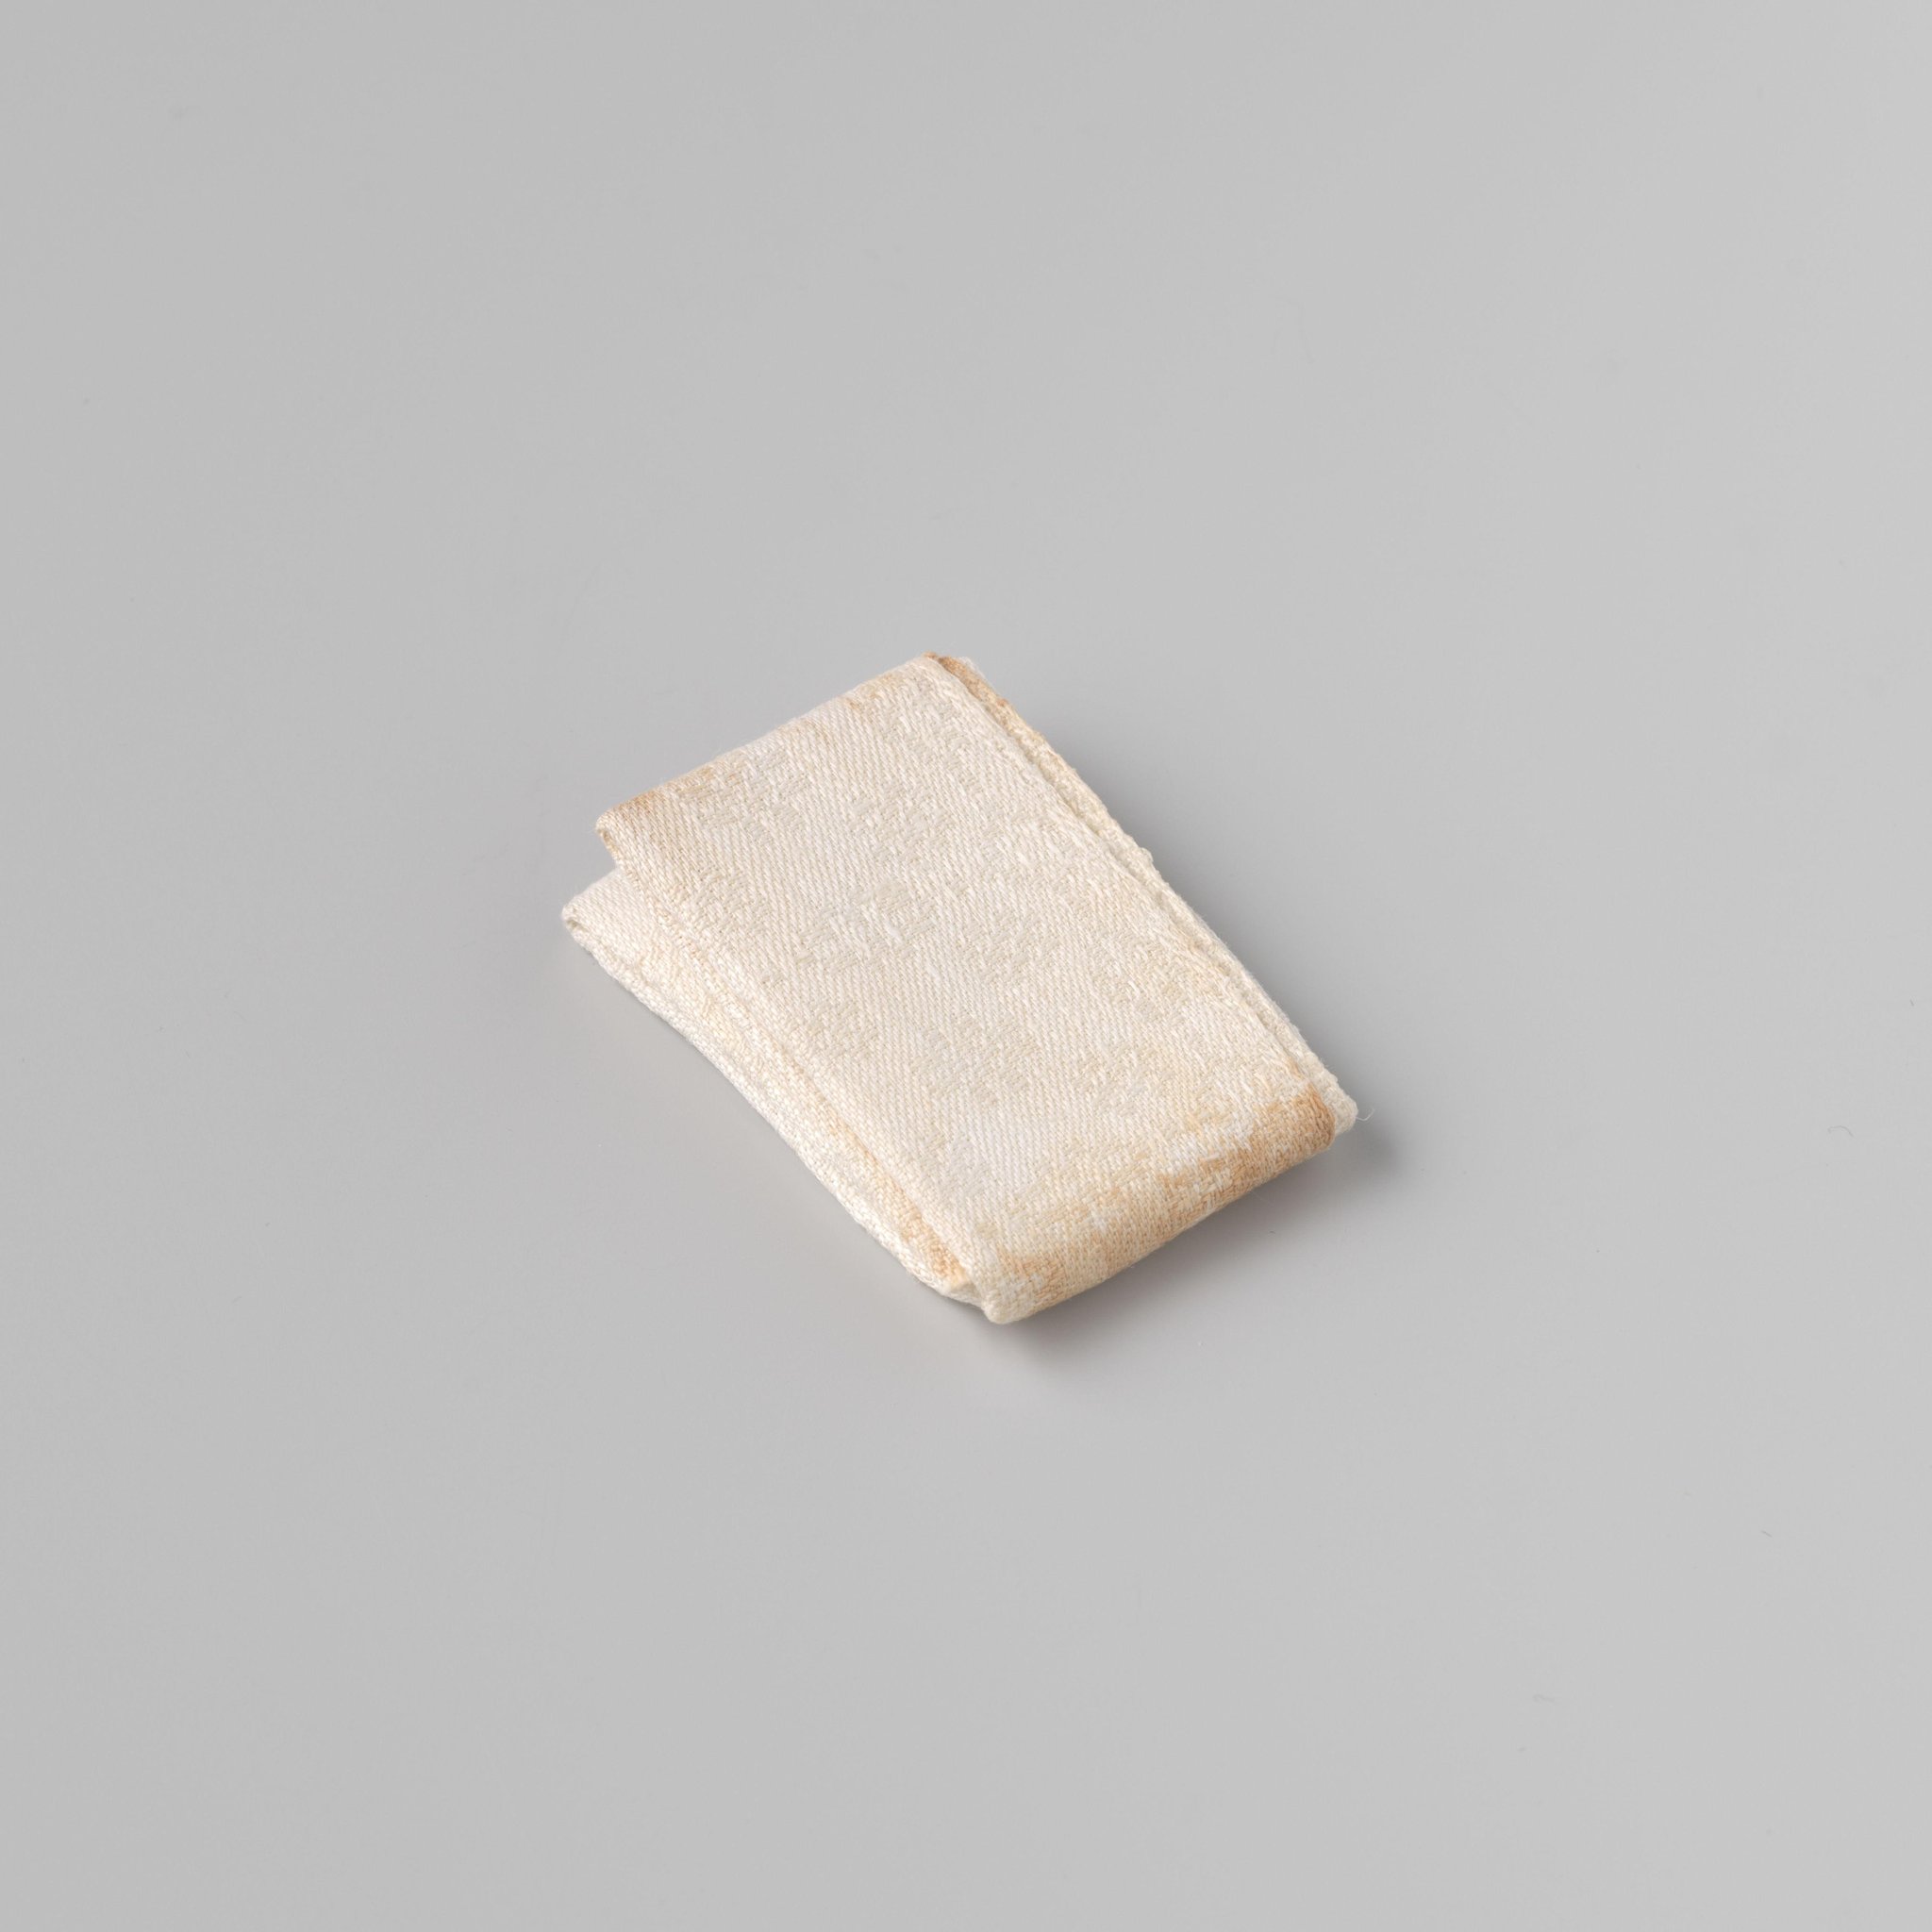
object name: dwaal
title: Linnen servet van damastweefsel met pellenpatroon (motief I), geen zomen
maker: Anonymous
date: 1690-1710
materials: linen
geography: amsterdam